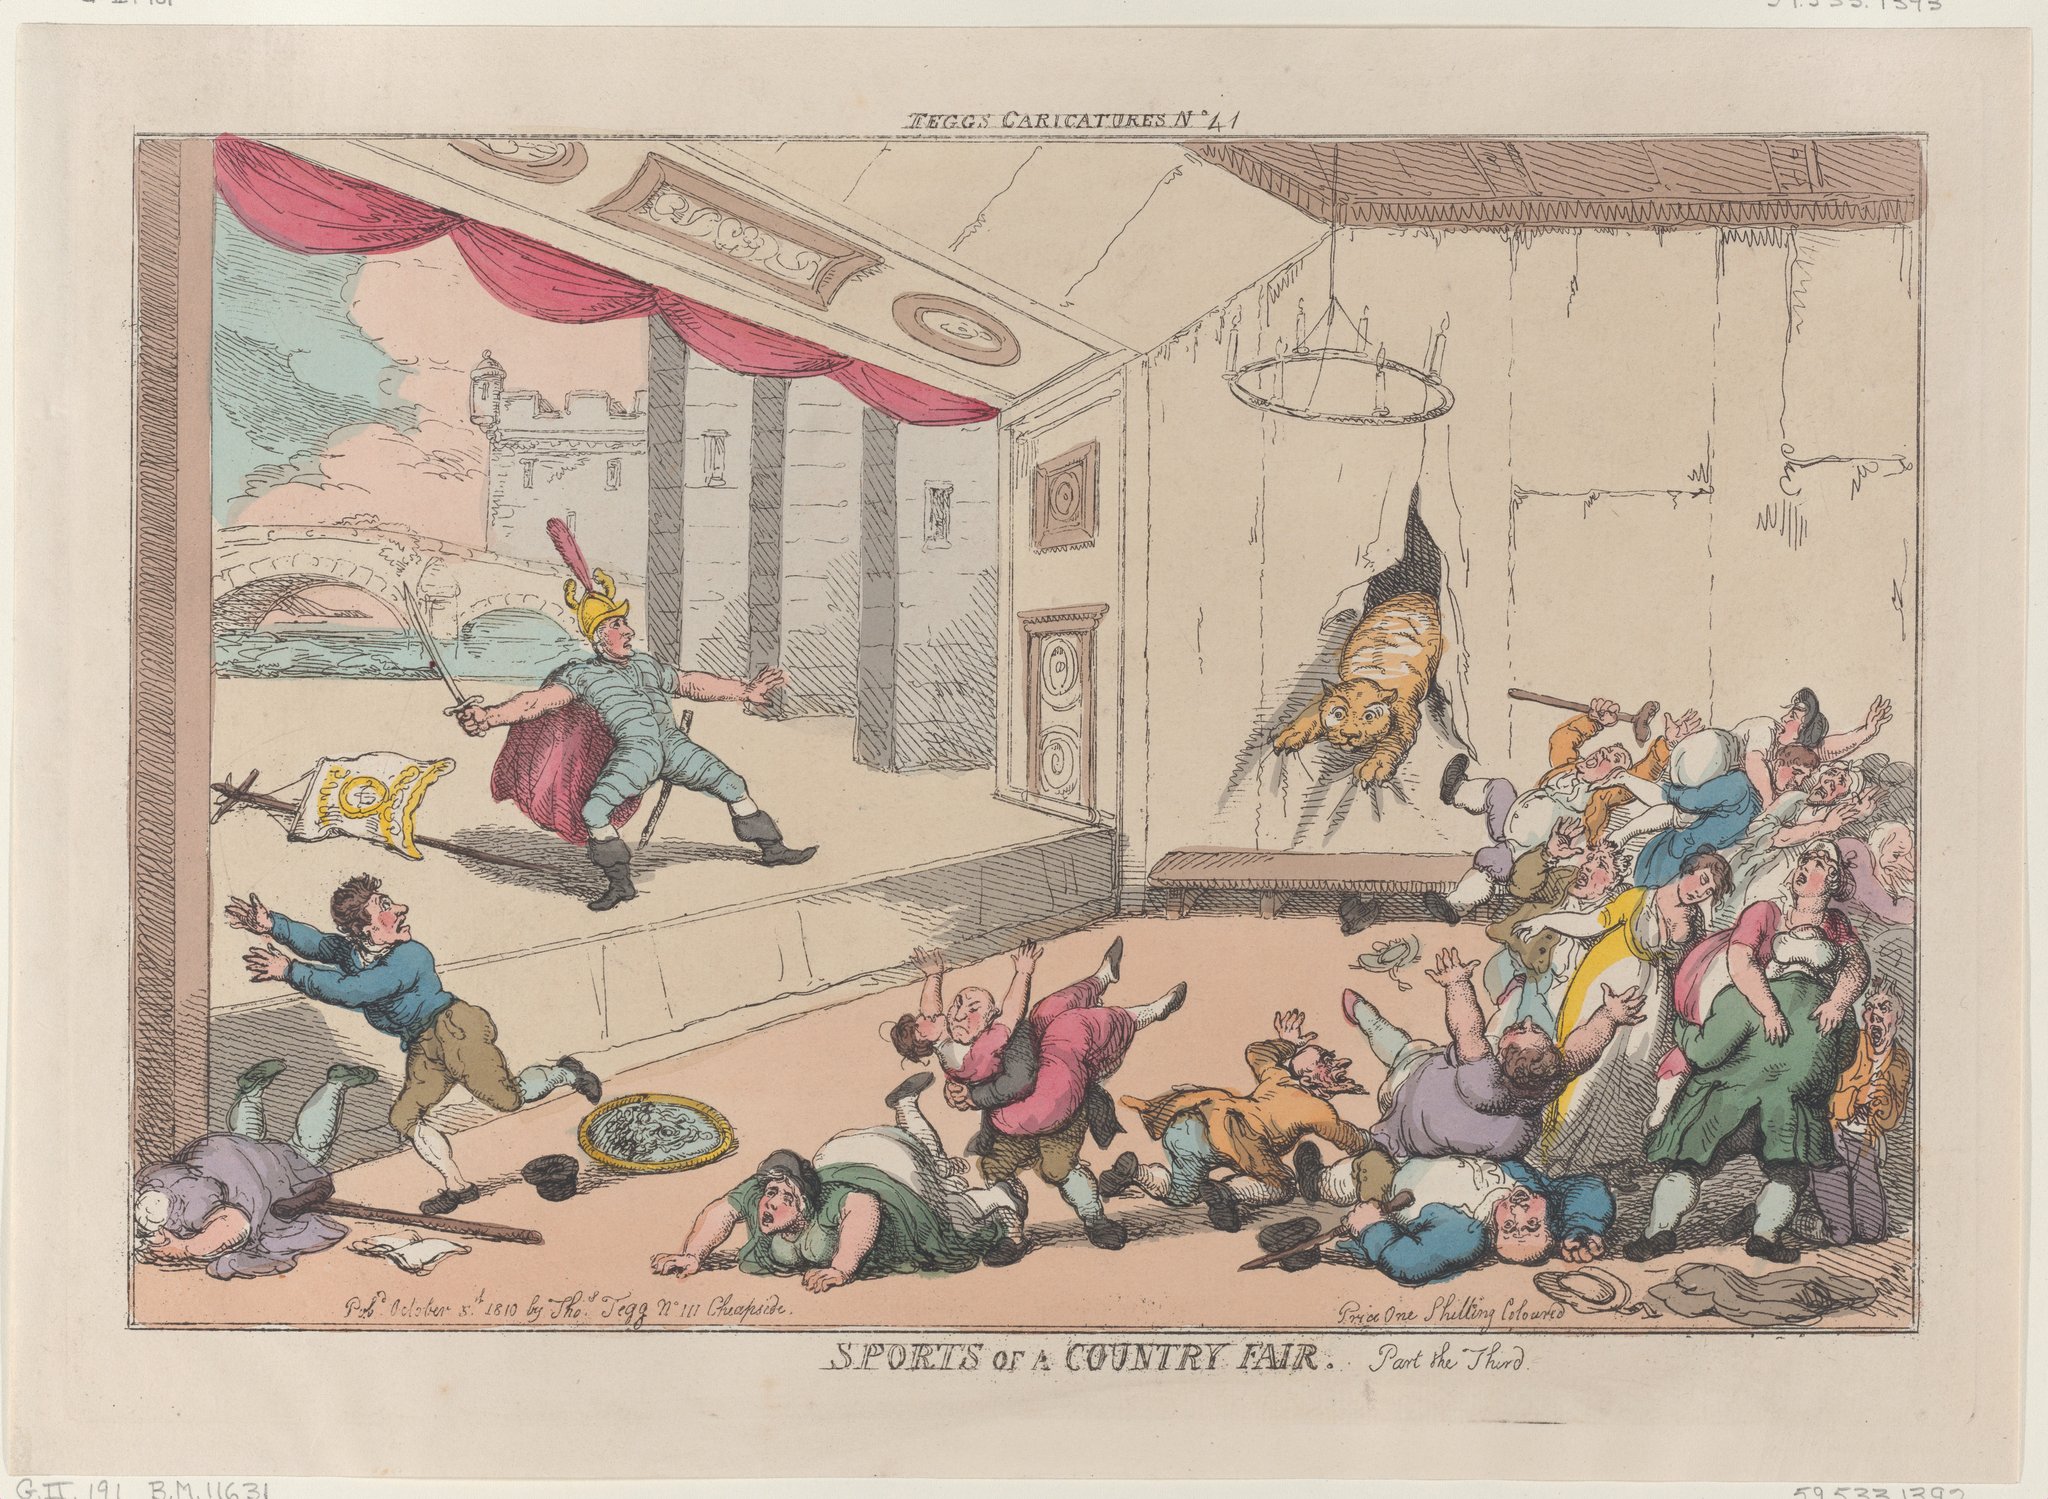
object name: print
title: Sports of a Country Fair, Part the Third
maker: thomas rowlandson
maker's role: artist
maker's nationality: british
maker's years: 1757-1827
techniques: etching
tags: satire,theatre,men,women,spectators,tigers